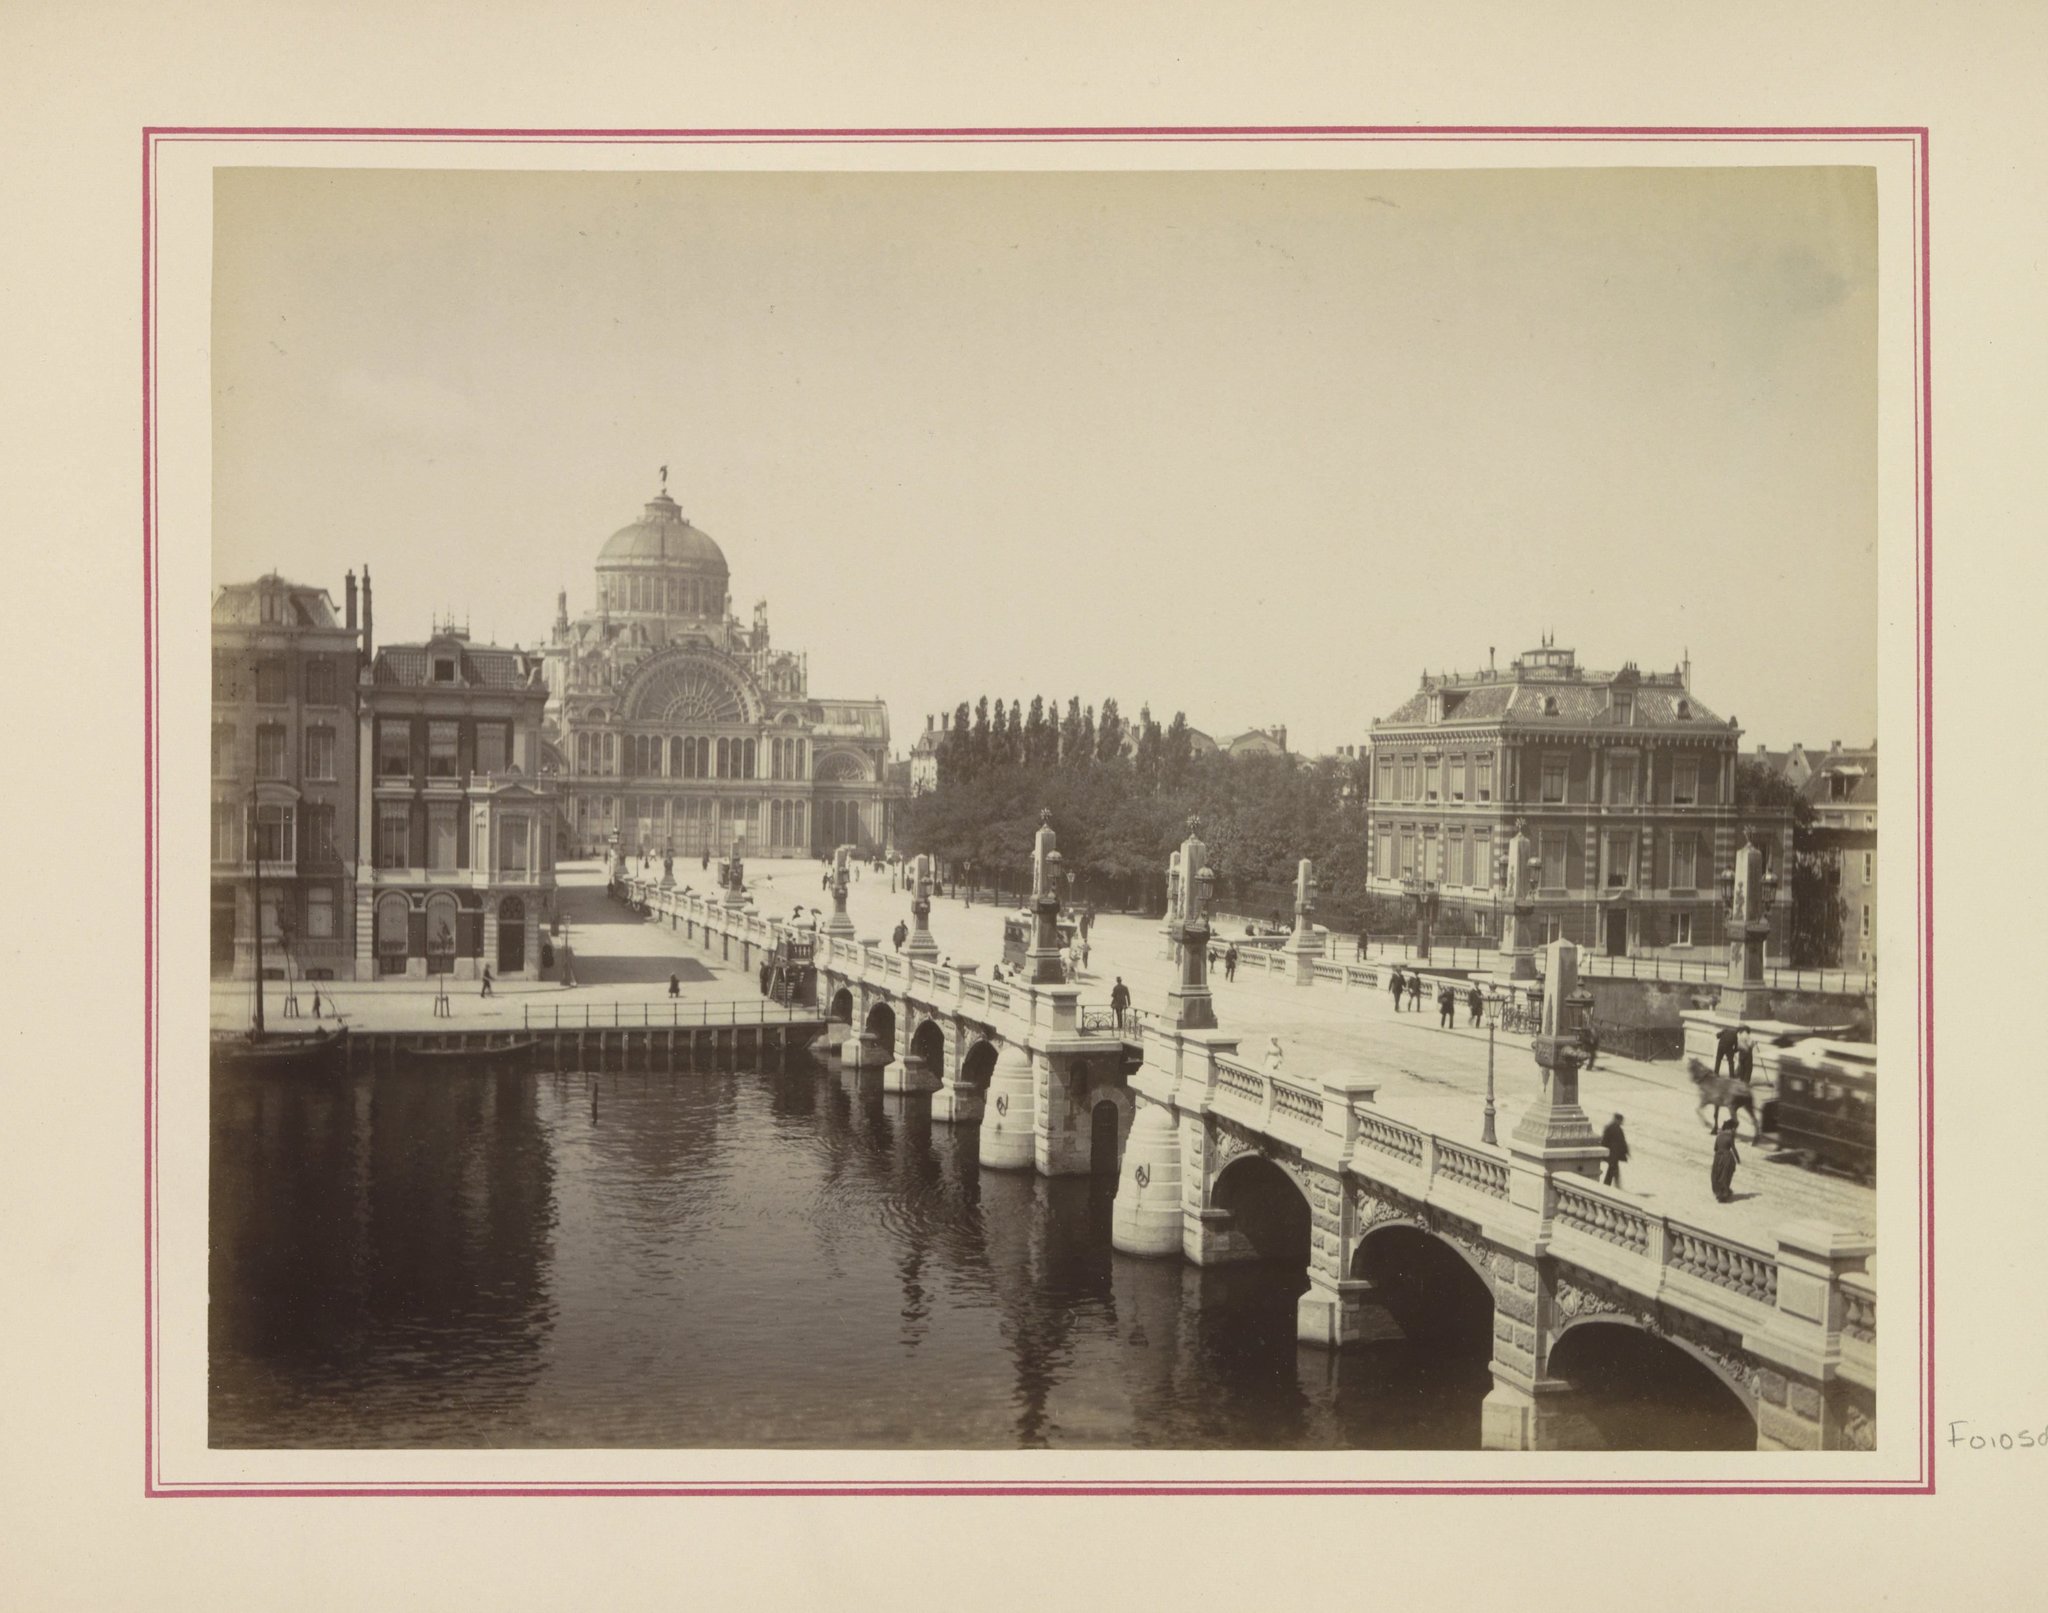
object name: photograph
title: Hogesluis over de Amstel in Amsterdam met aan het einde het Paleis voor Volksvlijt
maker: Anonymous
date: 1890-1900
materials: photographic support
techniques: albumen print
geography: amsterdam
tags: palace, bridge in city across river, canal, etc.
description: Onderdeel van Fotoalbum met opnames van bezienswaardigheden in Amsterdam.